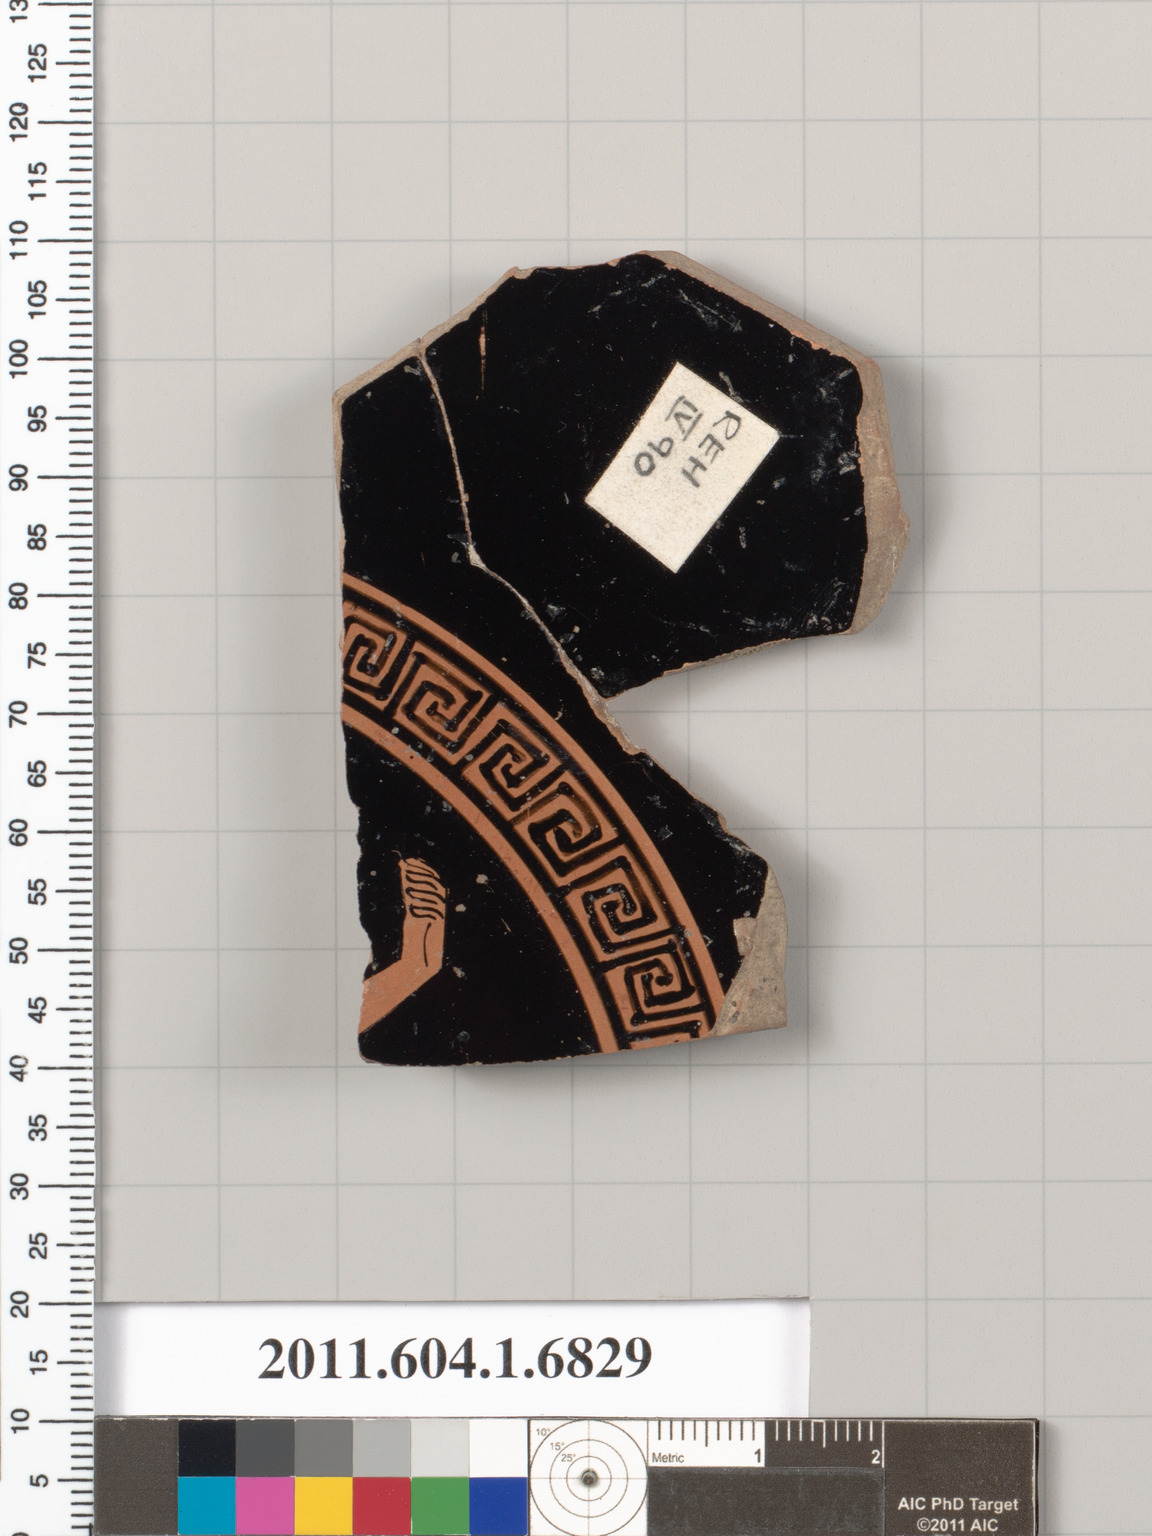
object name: kylix fragment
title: Terracotta fragment of a kylix (drinking cup)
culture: greek, attic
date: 490-470 BCE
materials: terracotta